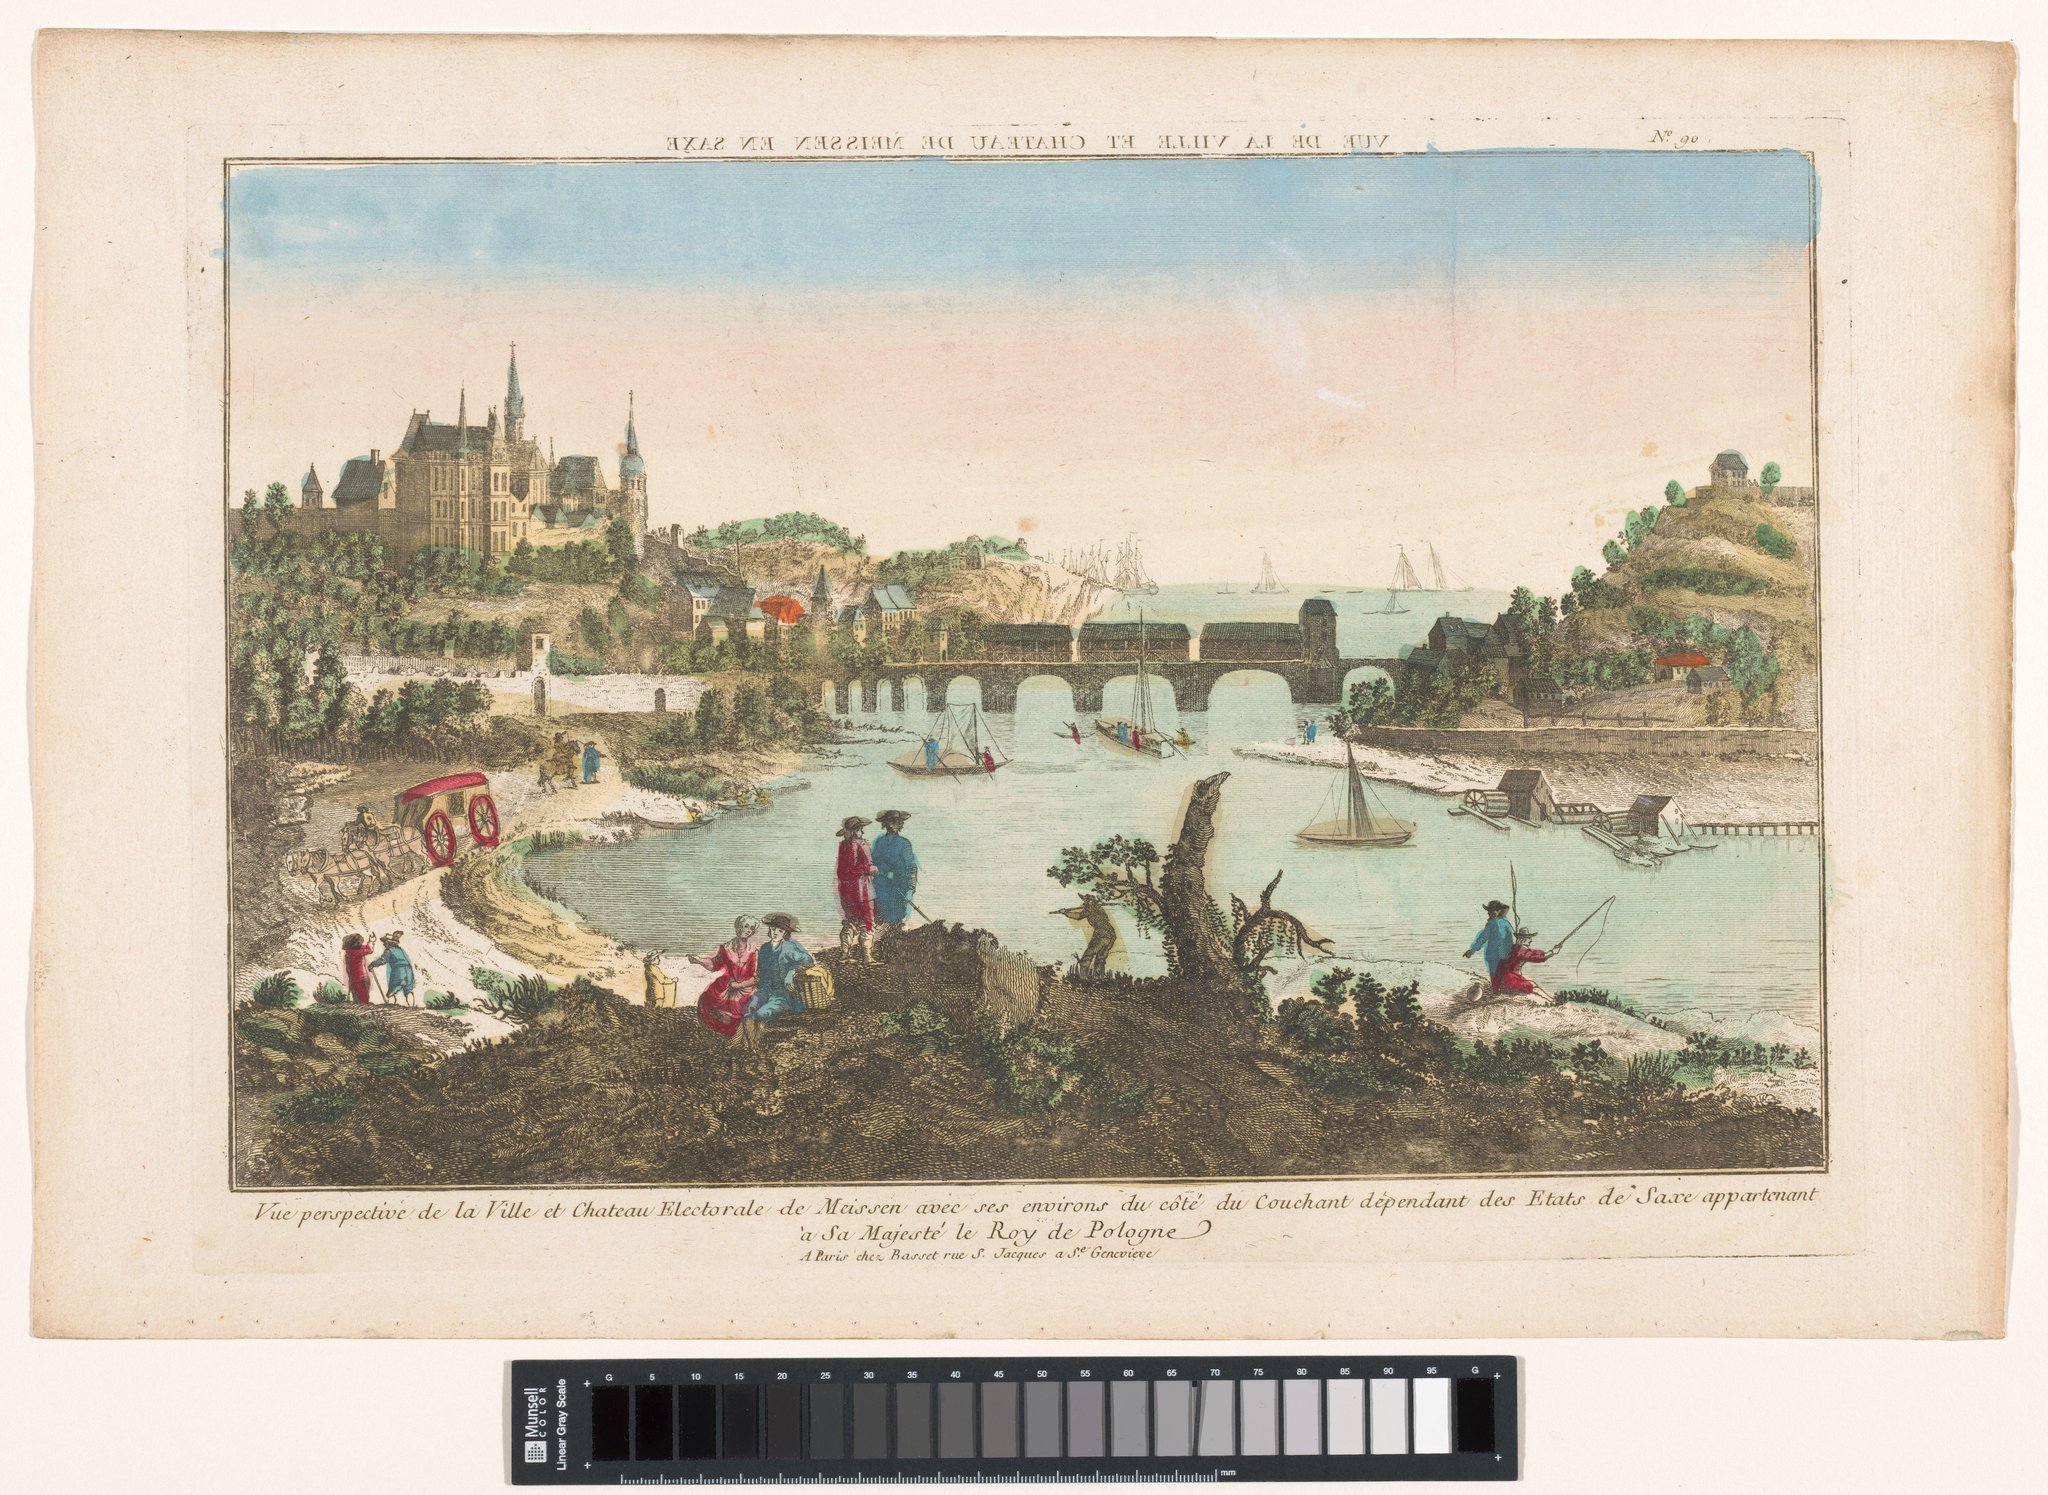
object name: print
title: Gezicht op het dorp Meissen en het kasteel Albrechtsburg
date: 1700-1799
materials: paper, watercolor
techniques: brush, etching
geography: france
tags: sailing-ship, sailing-boat, castle, landscape with bridge, viaduct or aqueduct, rowing-boat, canoe, etc., village (+ city(-scape) with figures, staffage)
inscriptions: collector's mark: Lugt 2166, watermark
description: Links staat het kasteel op een heuvel. Daaronder ligt het dorp met een bebouwde brug over de rivier de Elbe. Op de achtergrond liggen schepen en boten op het water. Genummerd: 90.